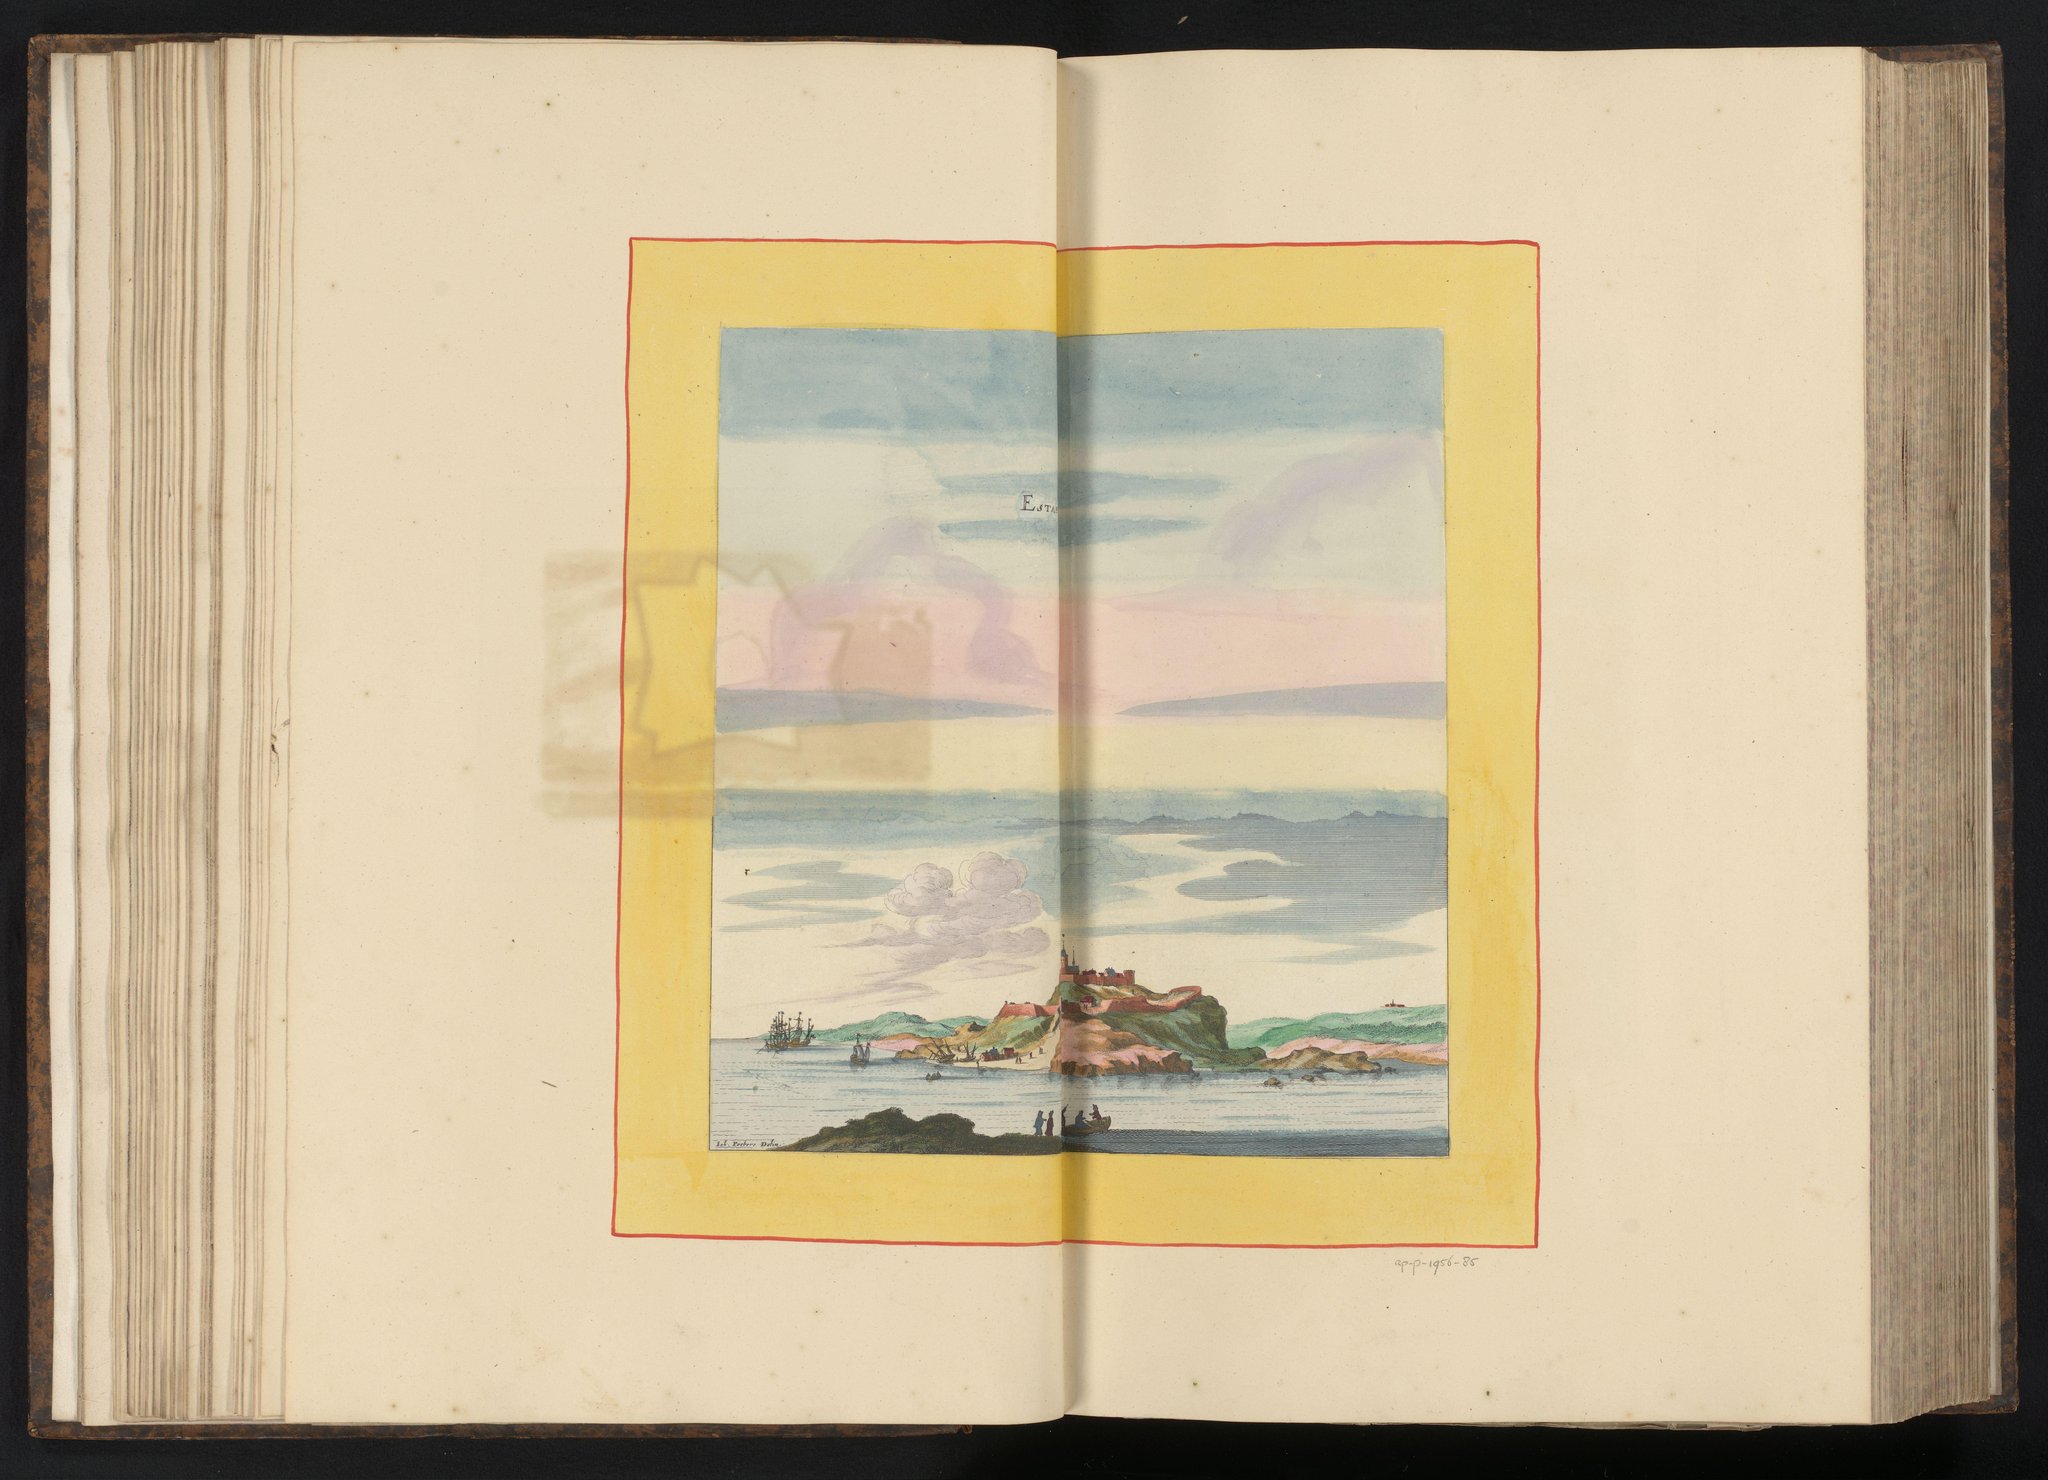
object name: album leaf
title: Estaples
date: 1656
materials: paper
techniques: engraving, etching, hand coloring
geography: frankfurt am main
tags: city-view in general; 'veduta'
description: Prent uit: Zeiller, Martin. Topographia Galliae. 13 dln. Frankfurt: Caspar Merian, 1656, dl. 2, na p. 22. De titel is uit de originele prent gesneden. Boven de gravure is een deel lucht en wolken (bij)geschilderd, waarin de titel gelijmd is. Origineel op één blad gedrukt met het gezicht op La Fère (RP-P-1956-87).